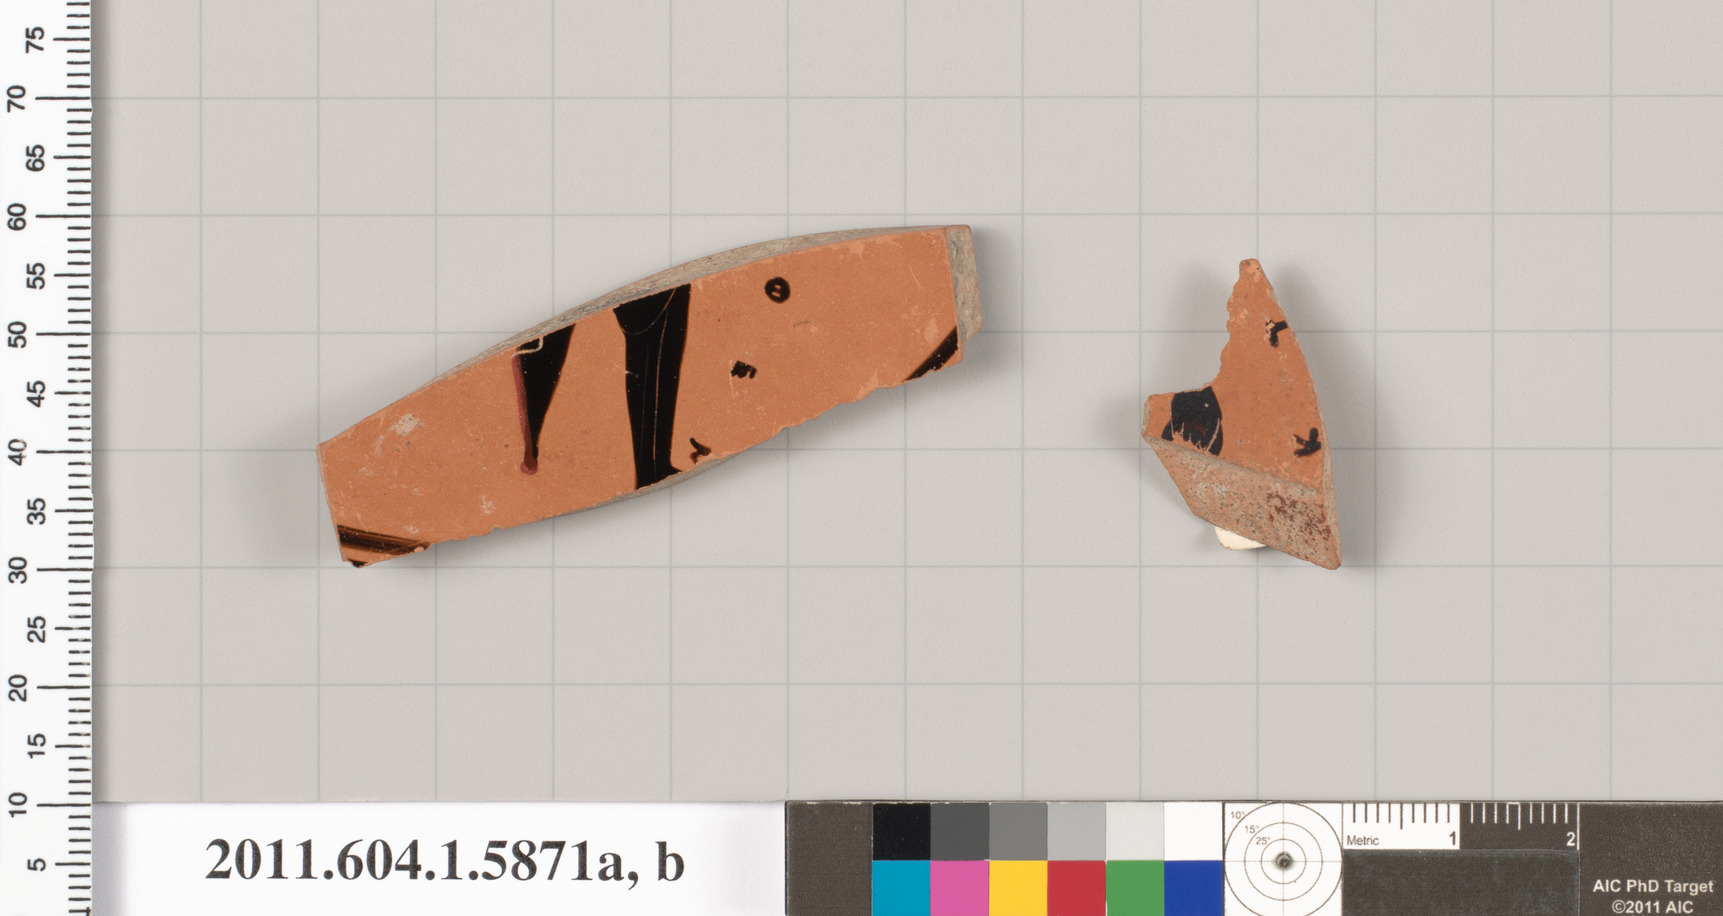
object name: kylix fragment, eye cup, bilingual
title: Terracotta fragments of a kylix (drinking cup)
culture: greek, attic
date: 433-567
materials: terracotta